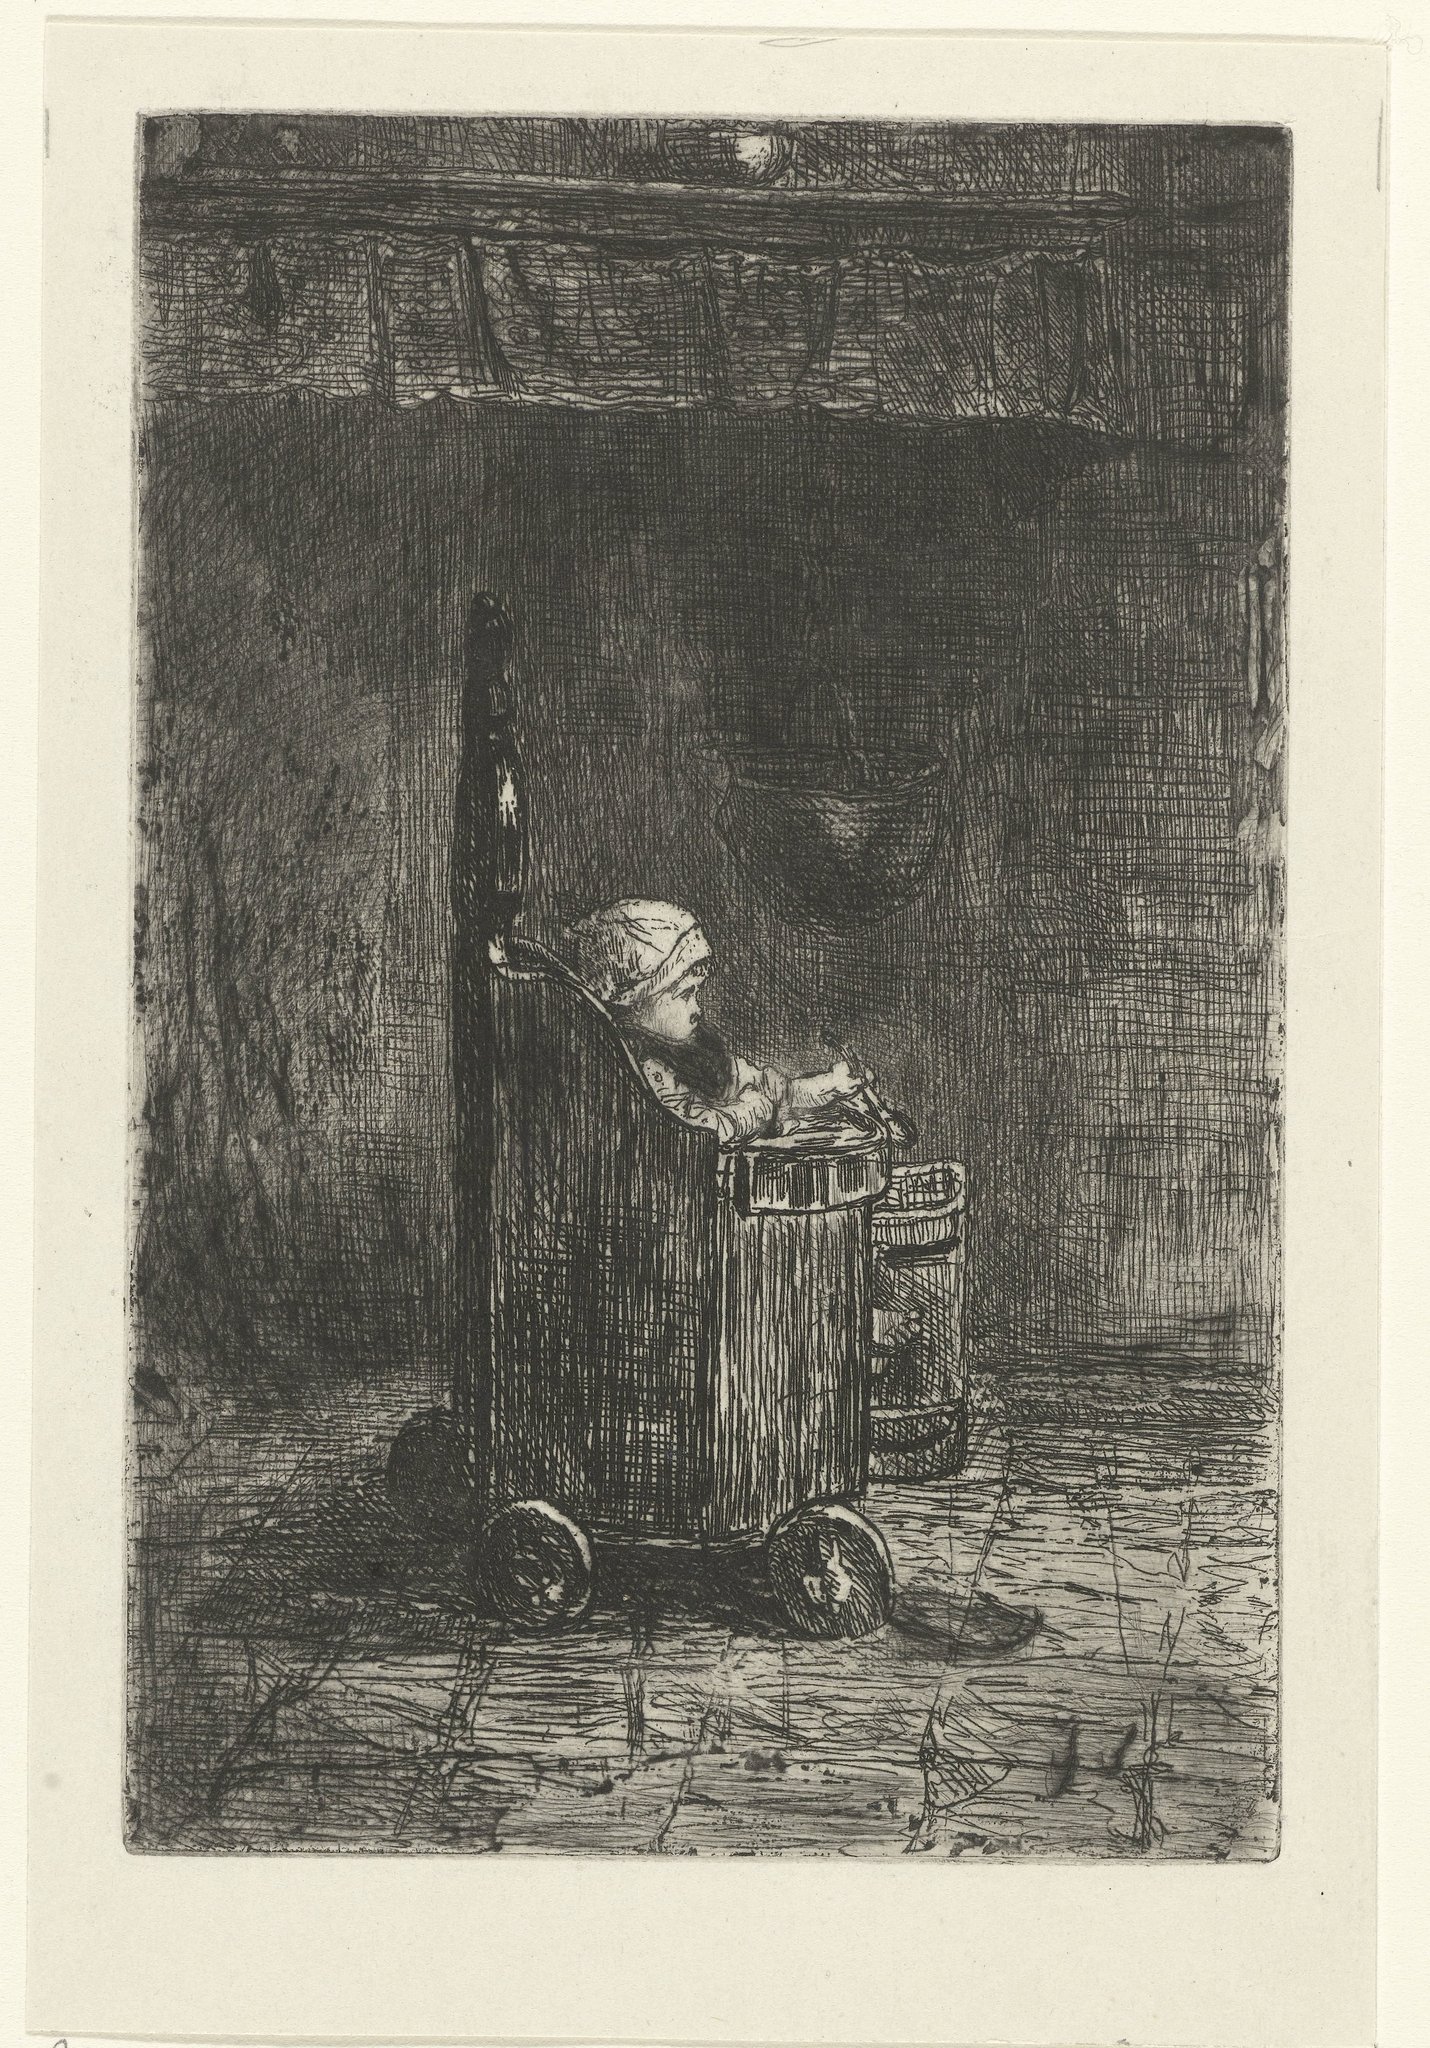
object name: print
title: Kind in de kinderstoel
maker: jozef israëls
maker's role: draughtsman, painter, print maker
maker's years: 1824-1911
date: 1835-1911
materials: paper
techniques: etching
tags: baby-chair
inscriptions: collector's mark: Lugt 2228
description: Een kind in een houten kinderstoel op wielen bij de schoorsteen.